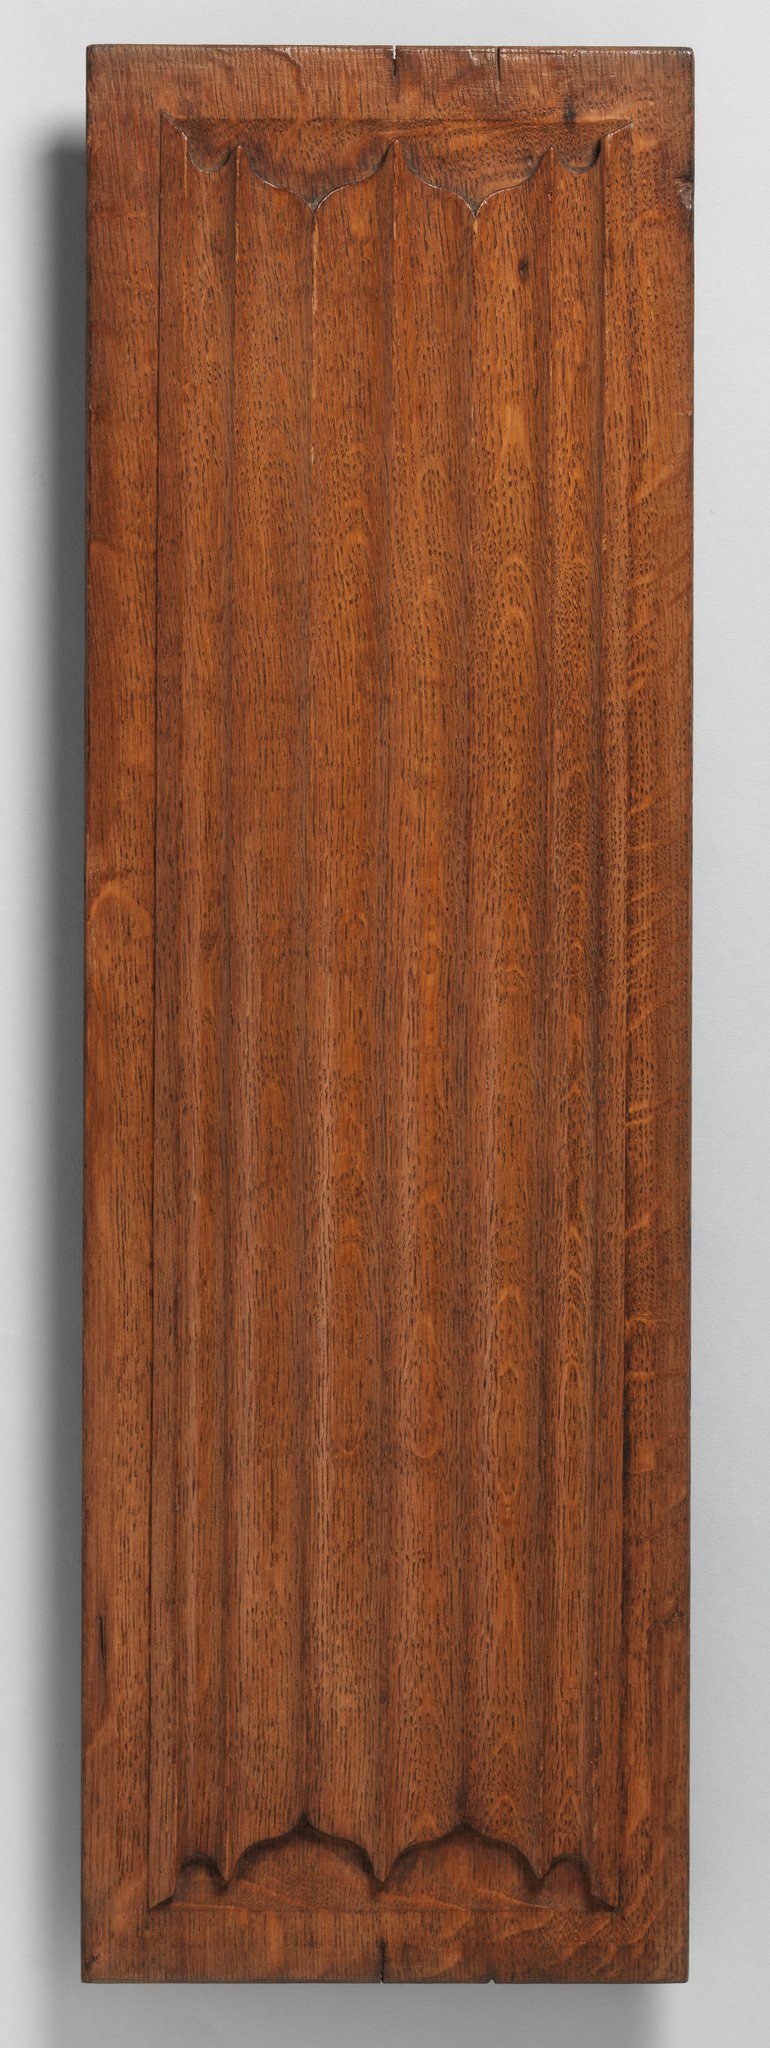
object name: panel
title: Panel from the Palace of Westminster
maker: augustus welby northmore pugin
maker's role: designer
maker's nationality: british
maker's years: 1812-1852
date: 1847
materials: wood